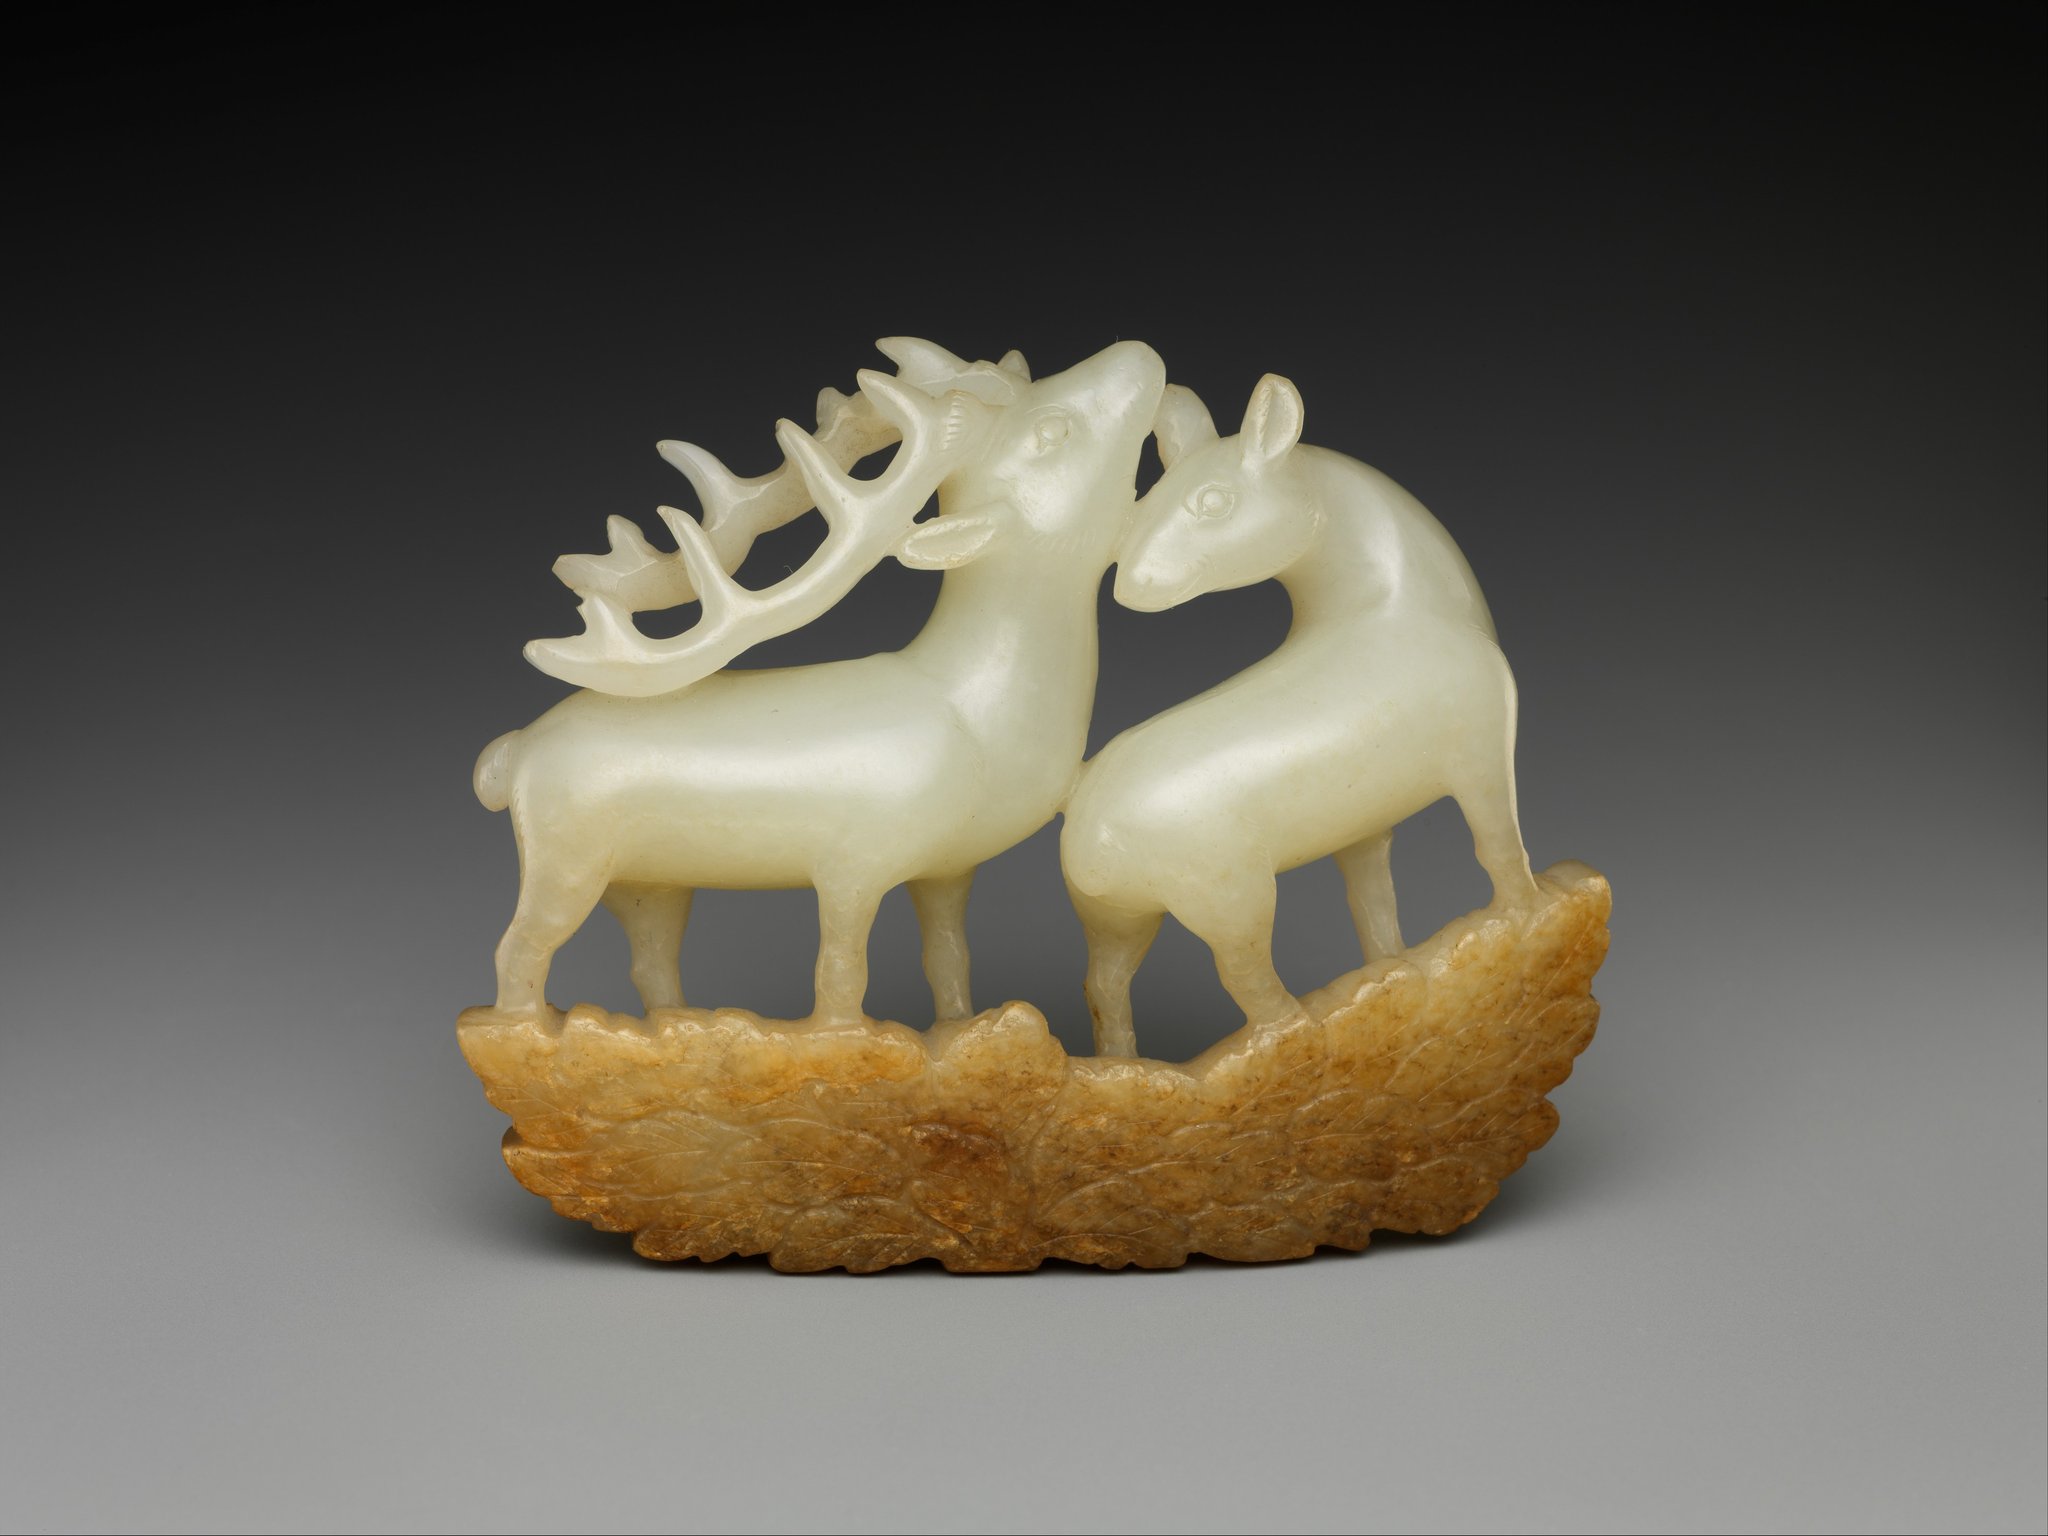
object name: ornament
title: Ornament with deer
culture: chinese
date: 901-1200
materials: jade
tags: deer